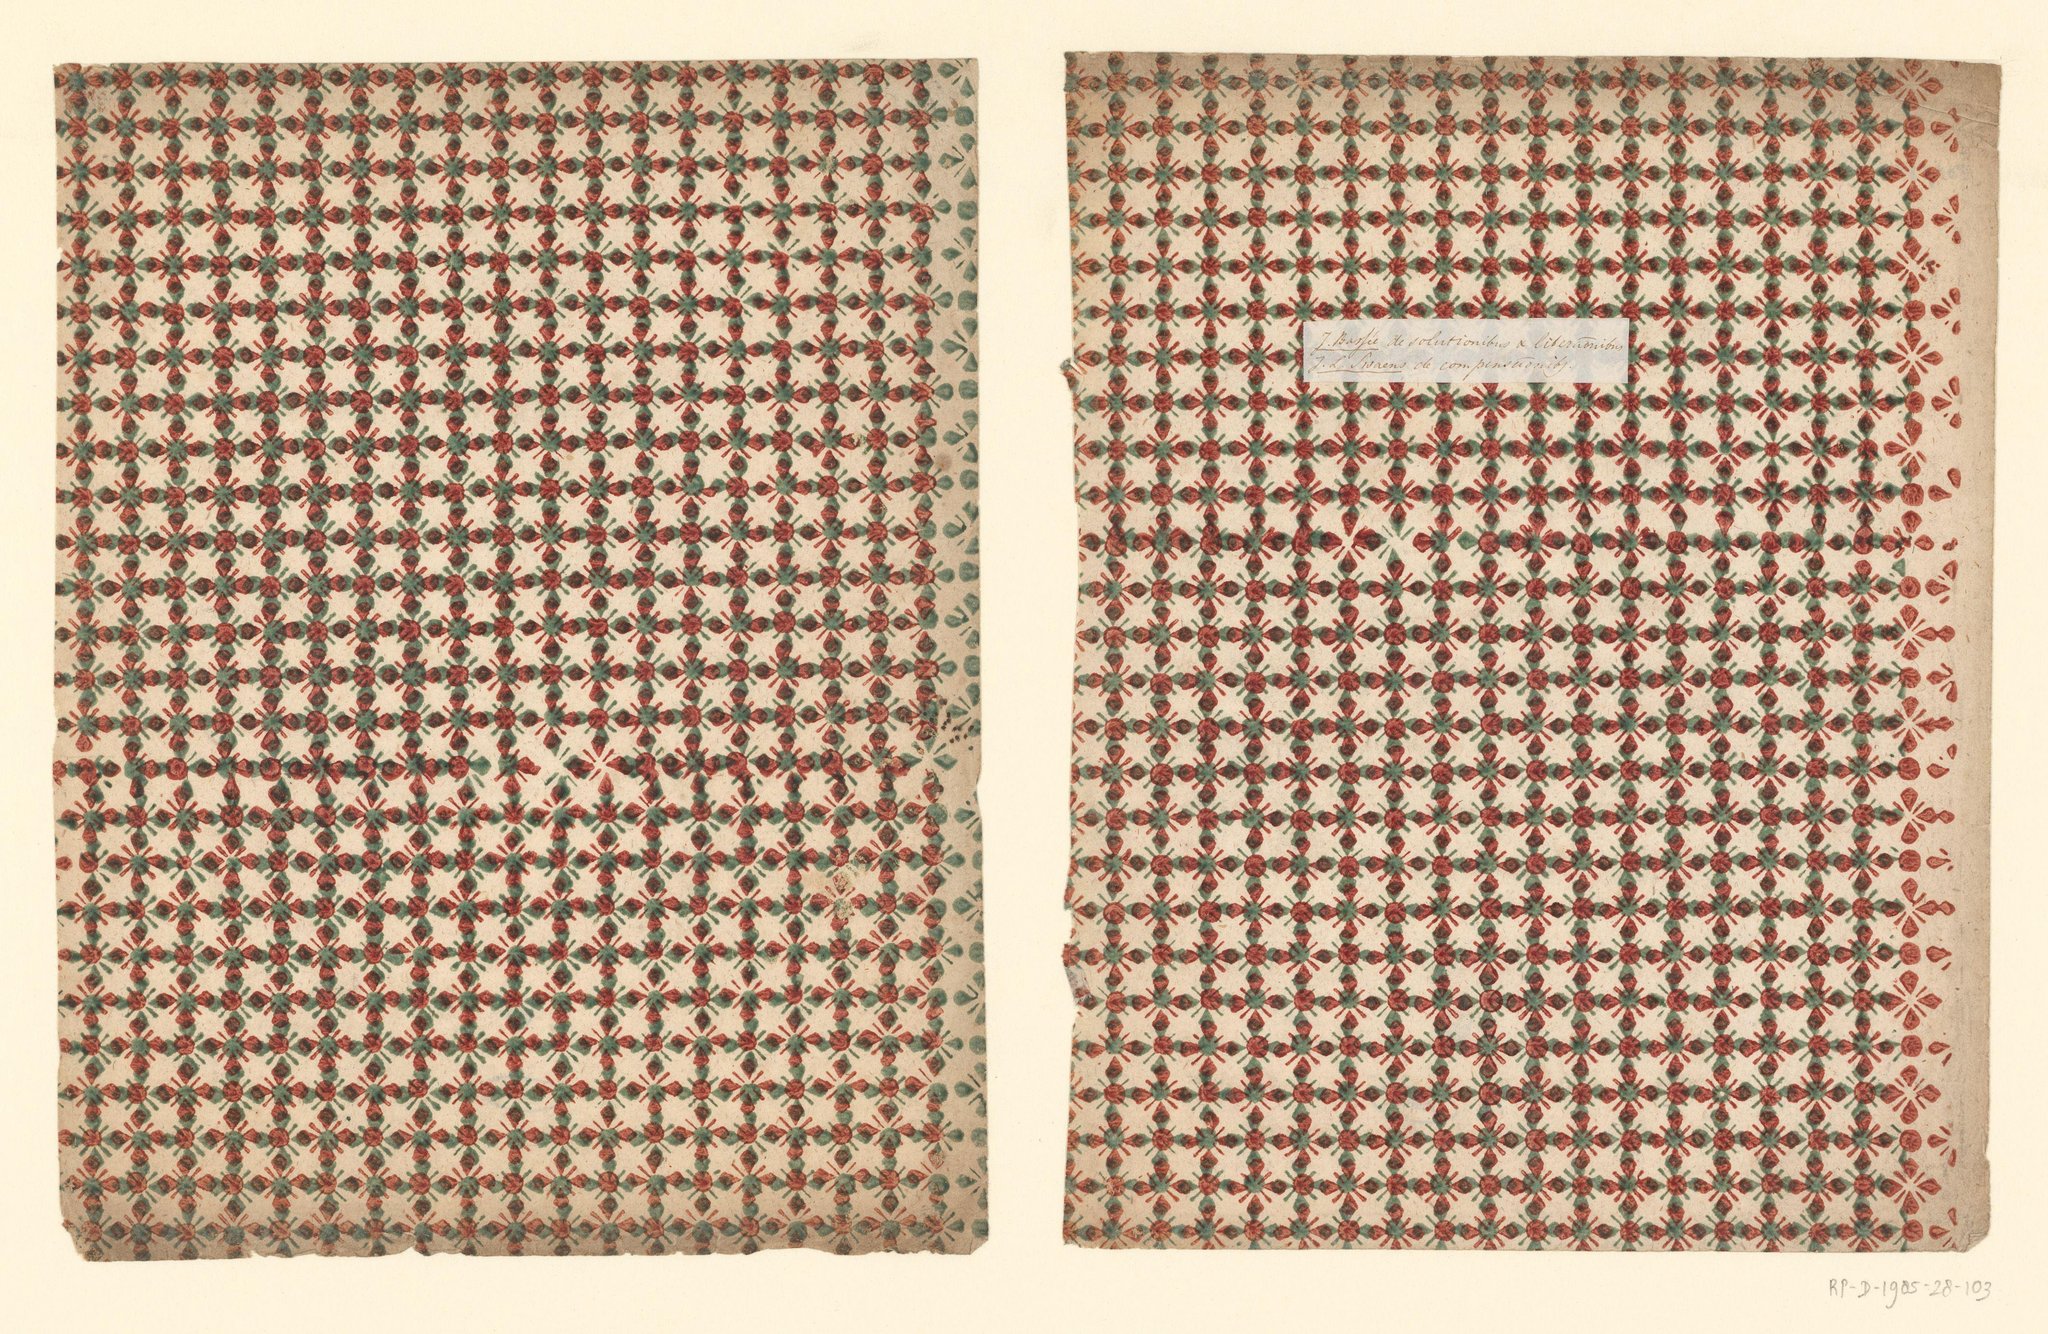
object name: printed paper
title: Twee bladen met rasterpatroon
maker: Anonymous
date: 1750-1900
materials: paper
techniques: printing block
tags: ornament ~ geometric motifs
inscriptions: collector's mark: Lugt 2228, collector's mark: Lugt 2760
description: Twee bladen met rasterpatroon. Met etiket met opschrift: 'J. Bassée ... compens...'. Omslag bestaande uit twee losse delen.